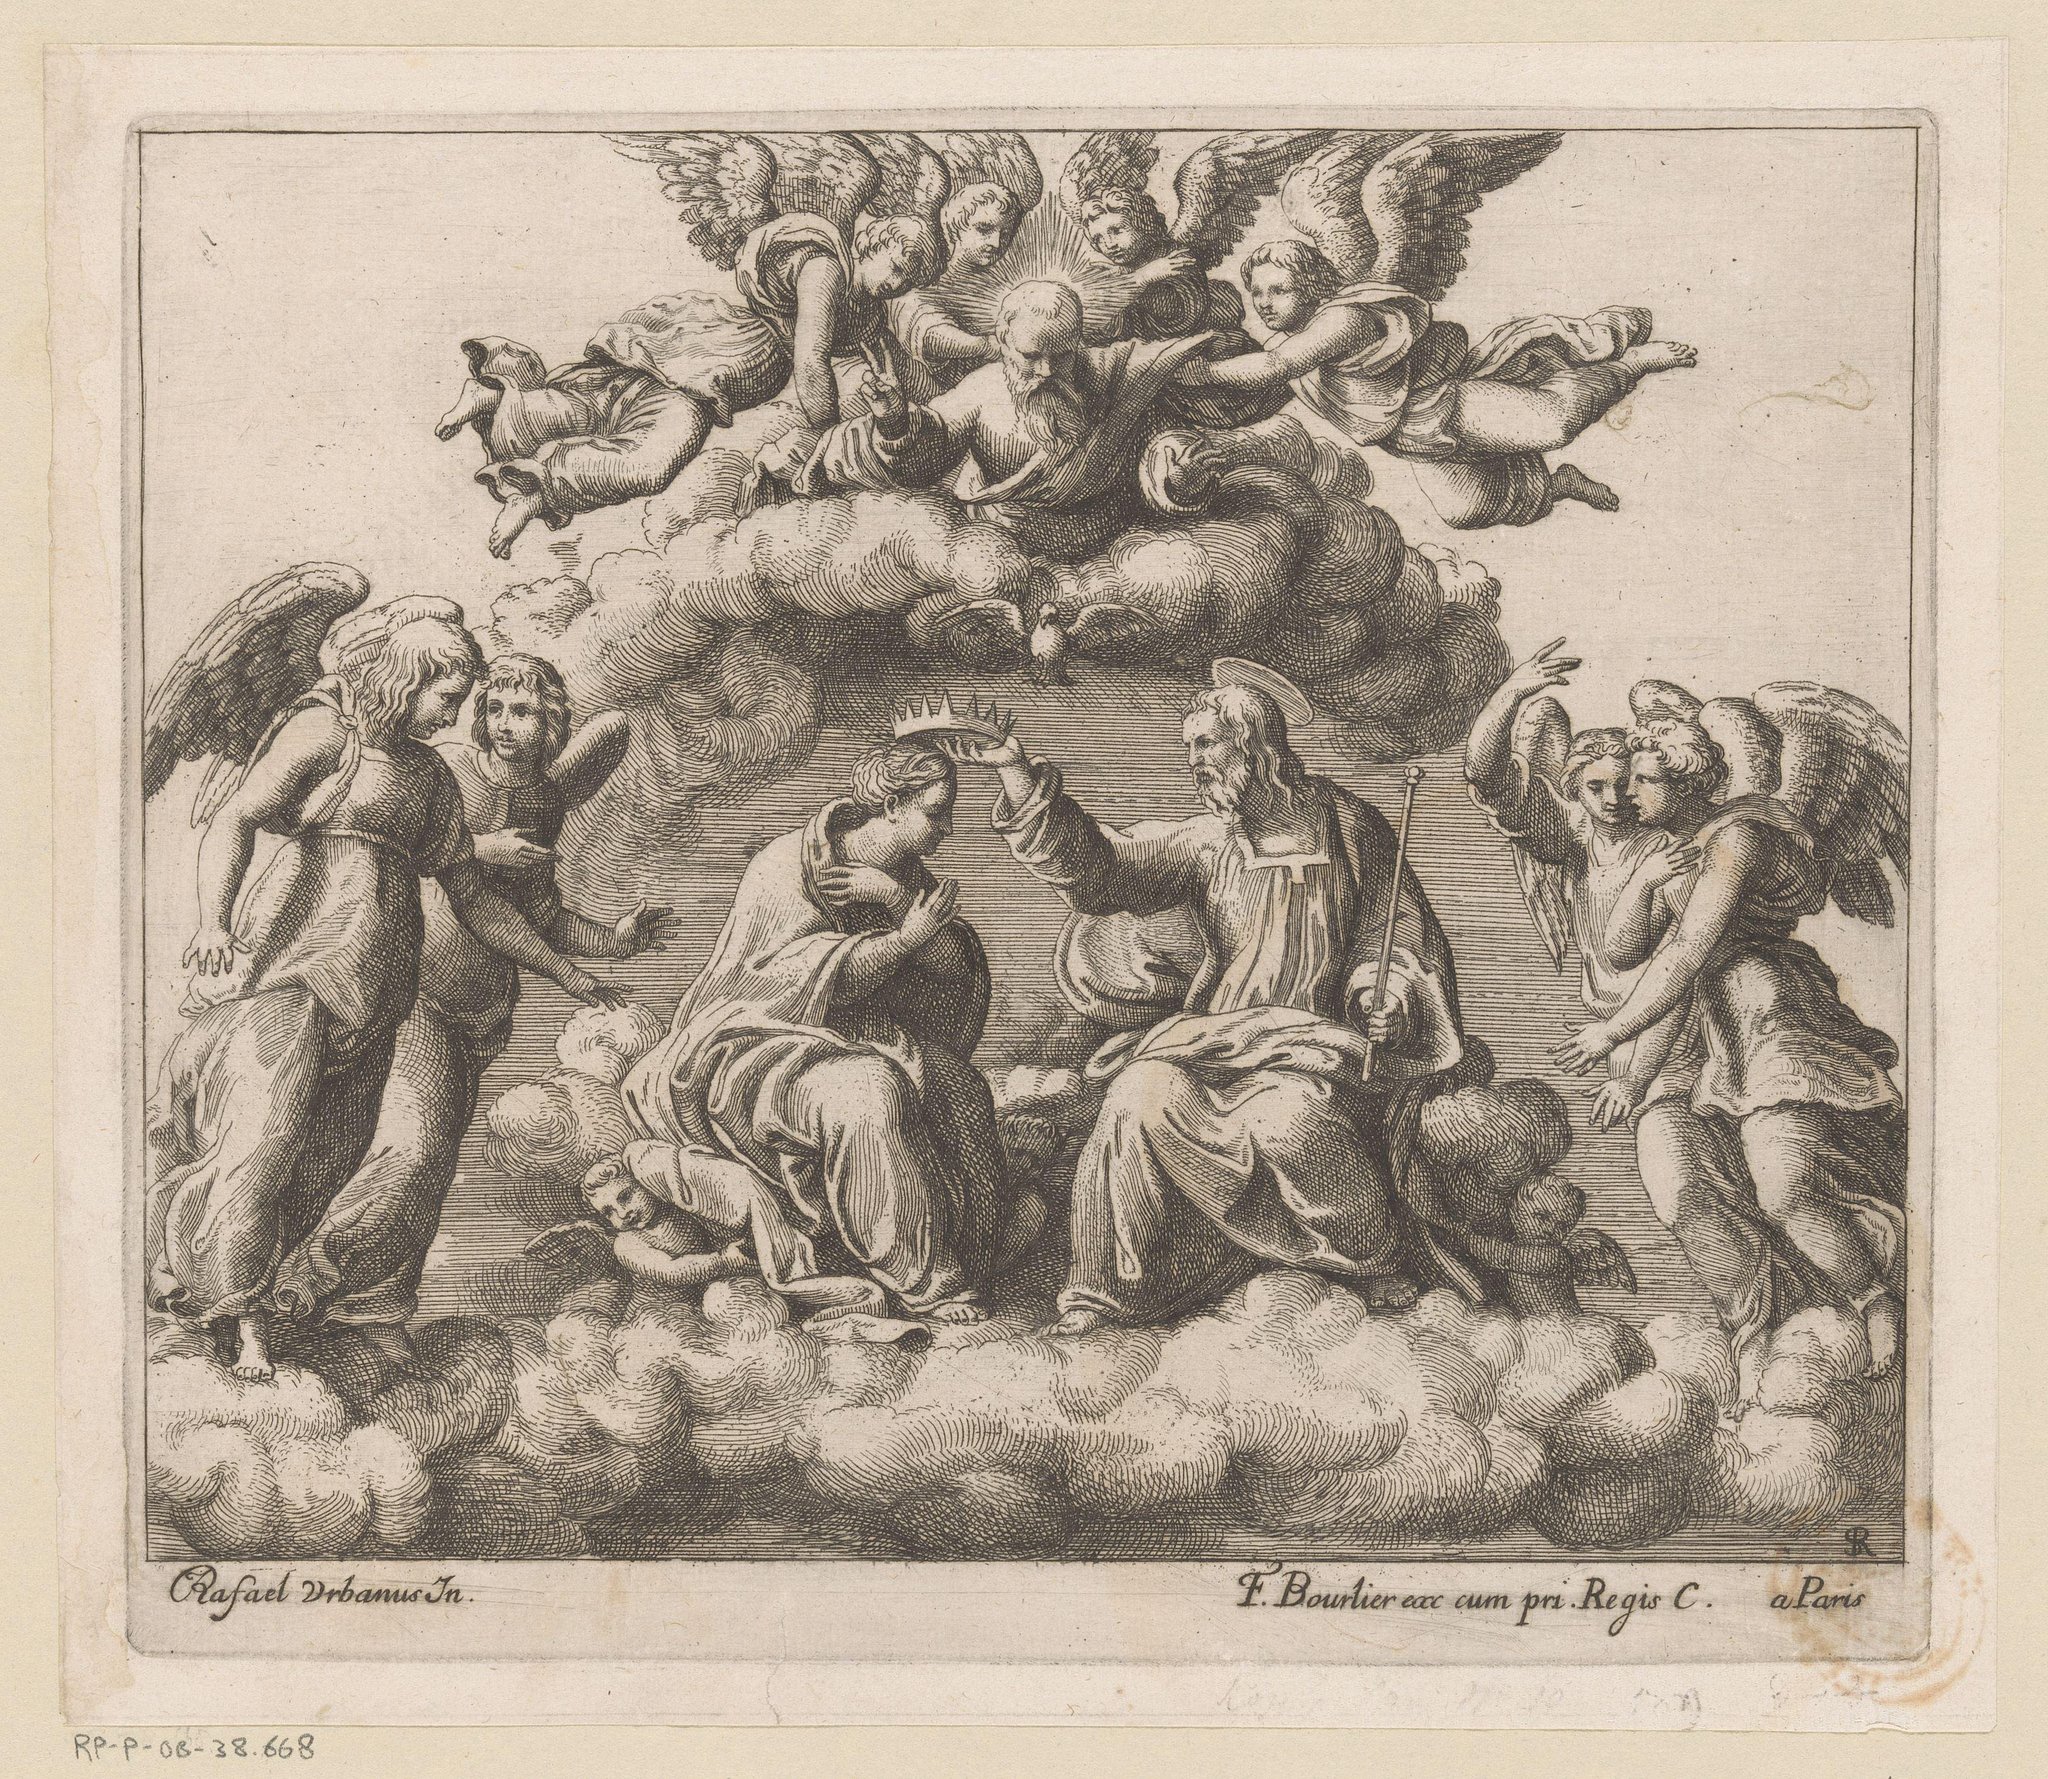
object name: print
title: Maria gekroond door Christus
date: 1651-1682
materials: paper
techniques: etching, intaglio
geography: france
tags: coronation of mary by christ, angels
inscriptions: collector's mark: Lugt 240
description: Op een wolkenpartij wordt Maria gekroond door Christus. Boven hen God de Vader en de Heilige Geest als duif.